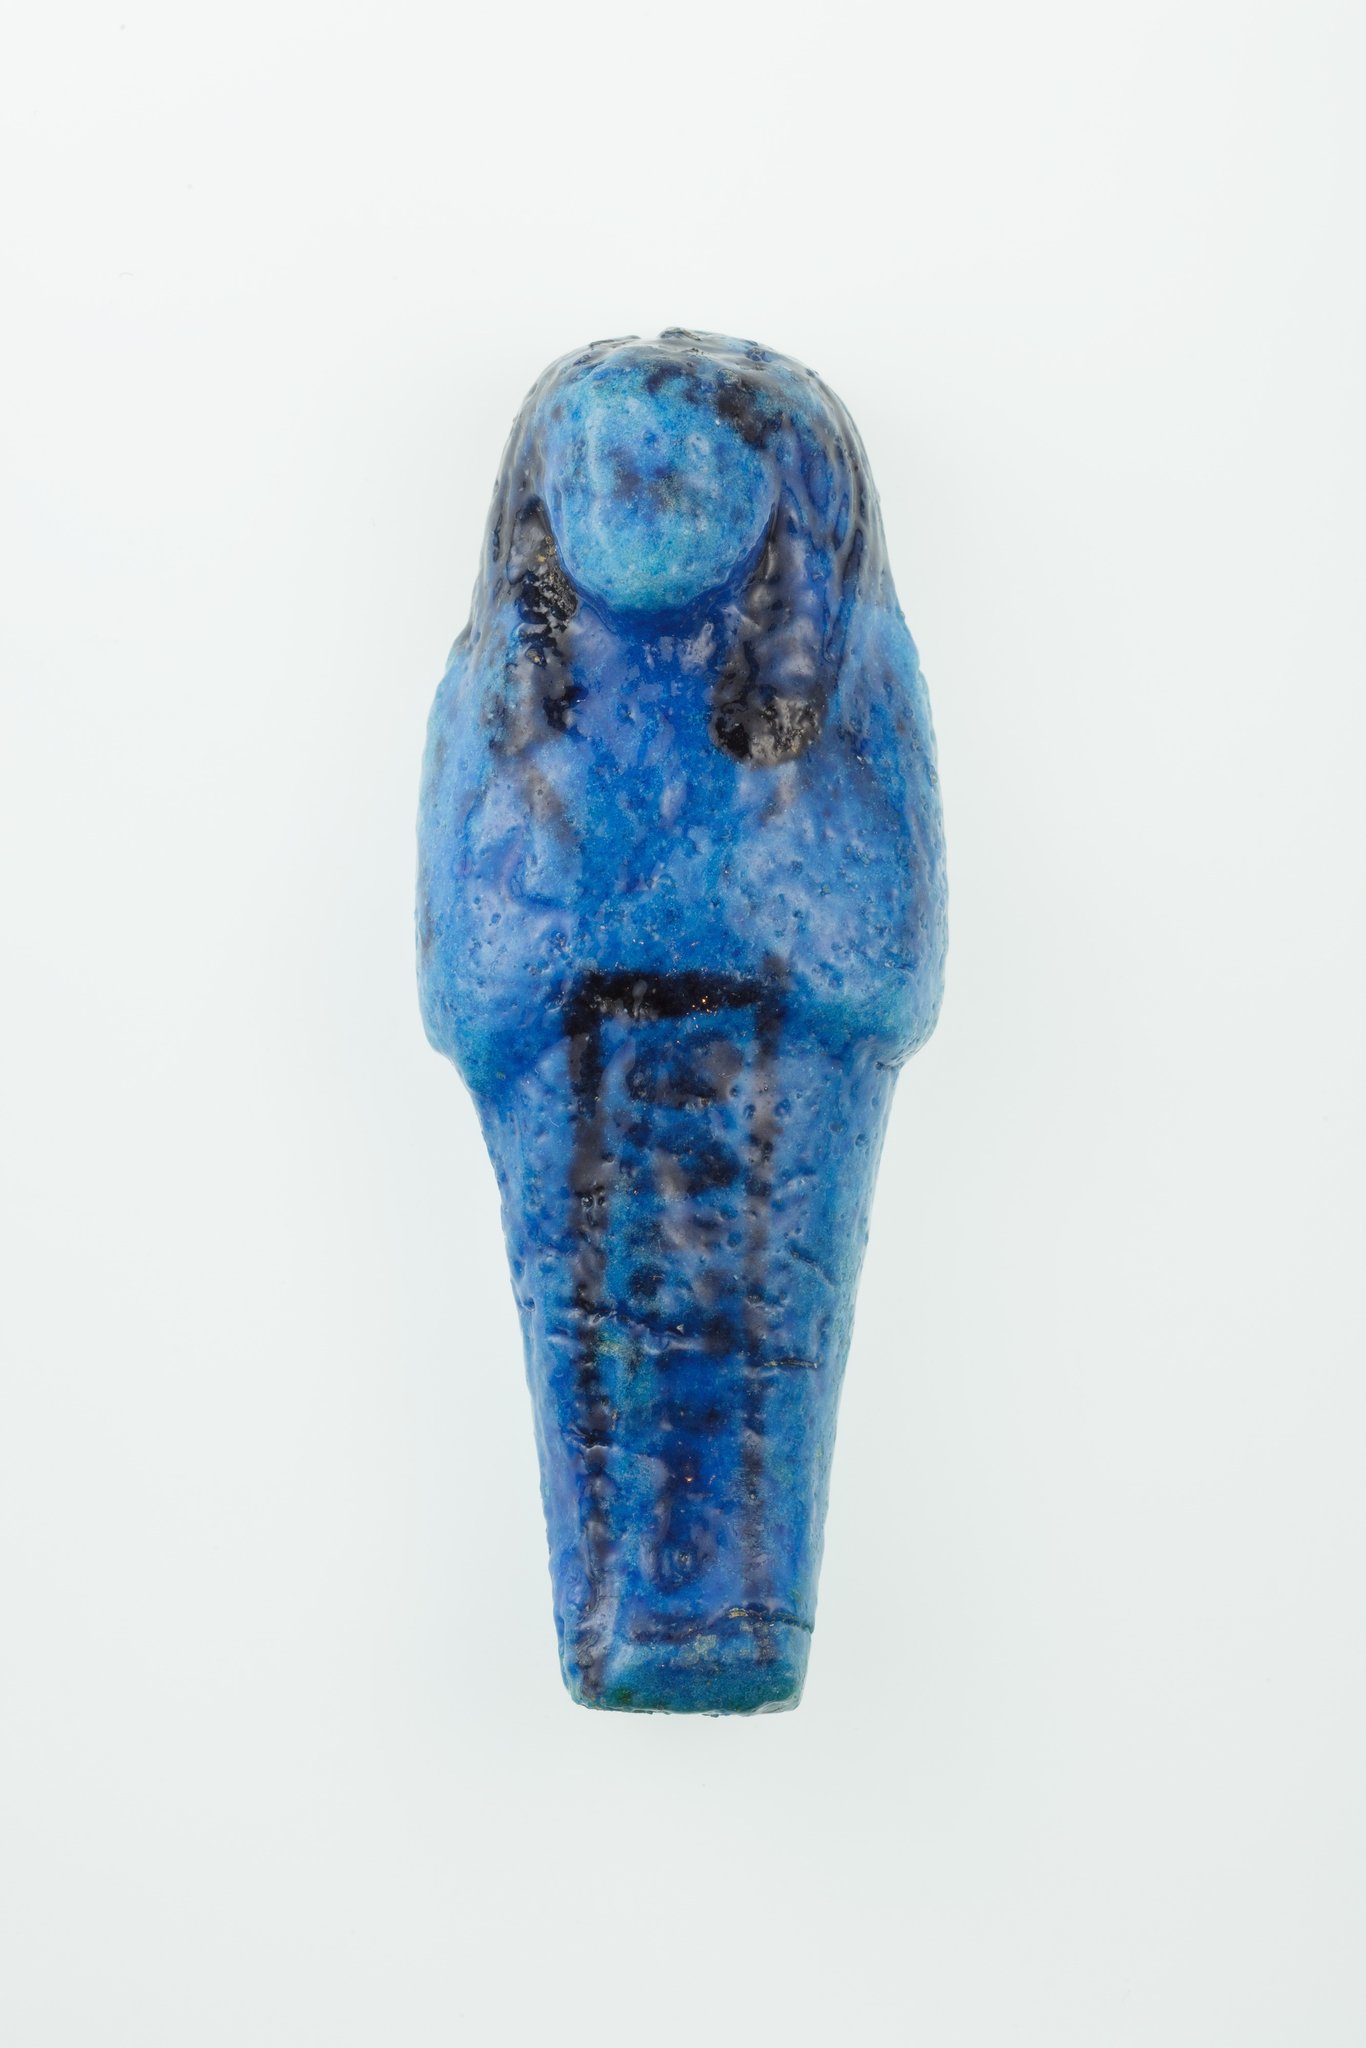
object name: shabti, worker, nauny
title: Worker Shabti of Nauny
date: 1050 BCE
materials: faience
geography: egypt